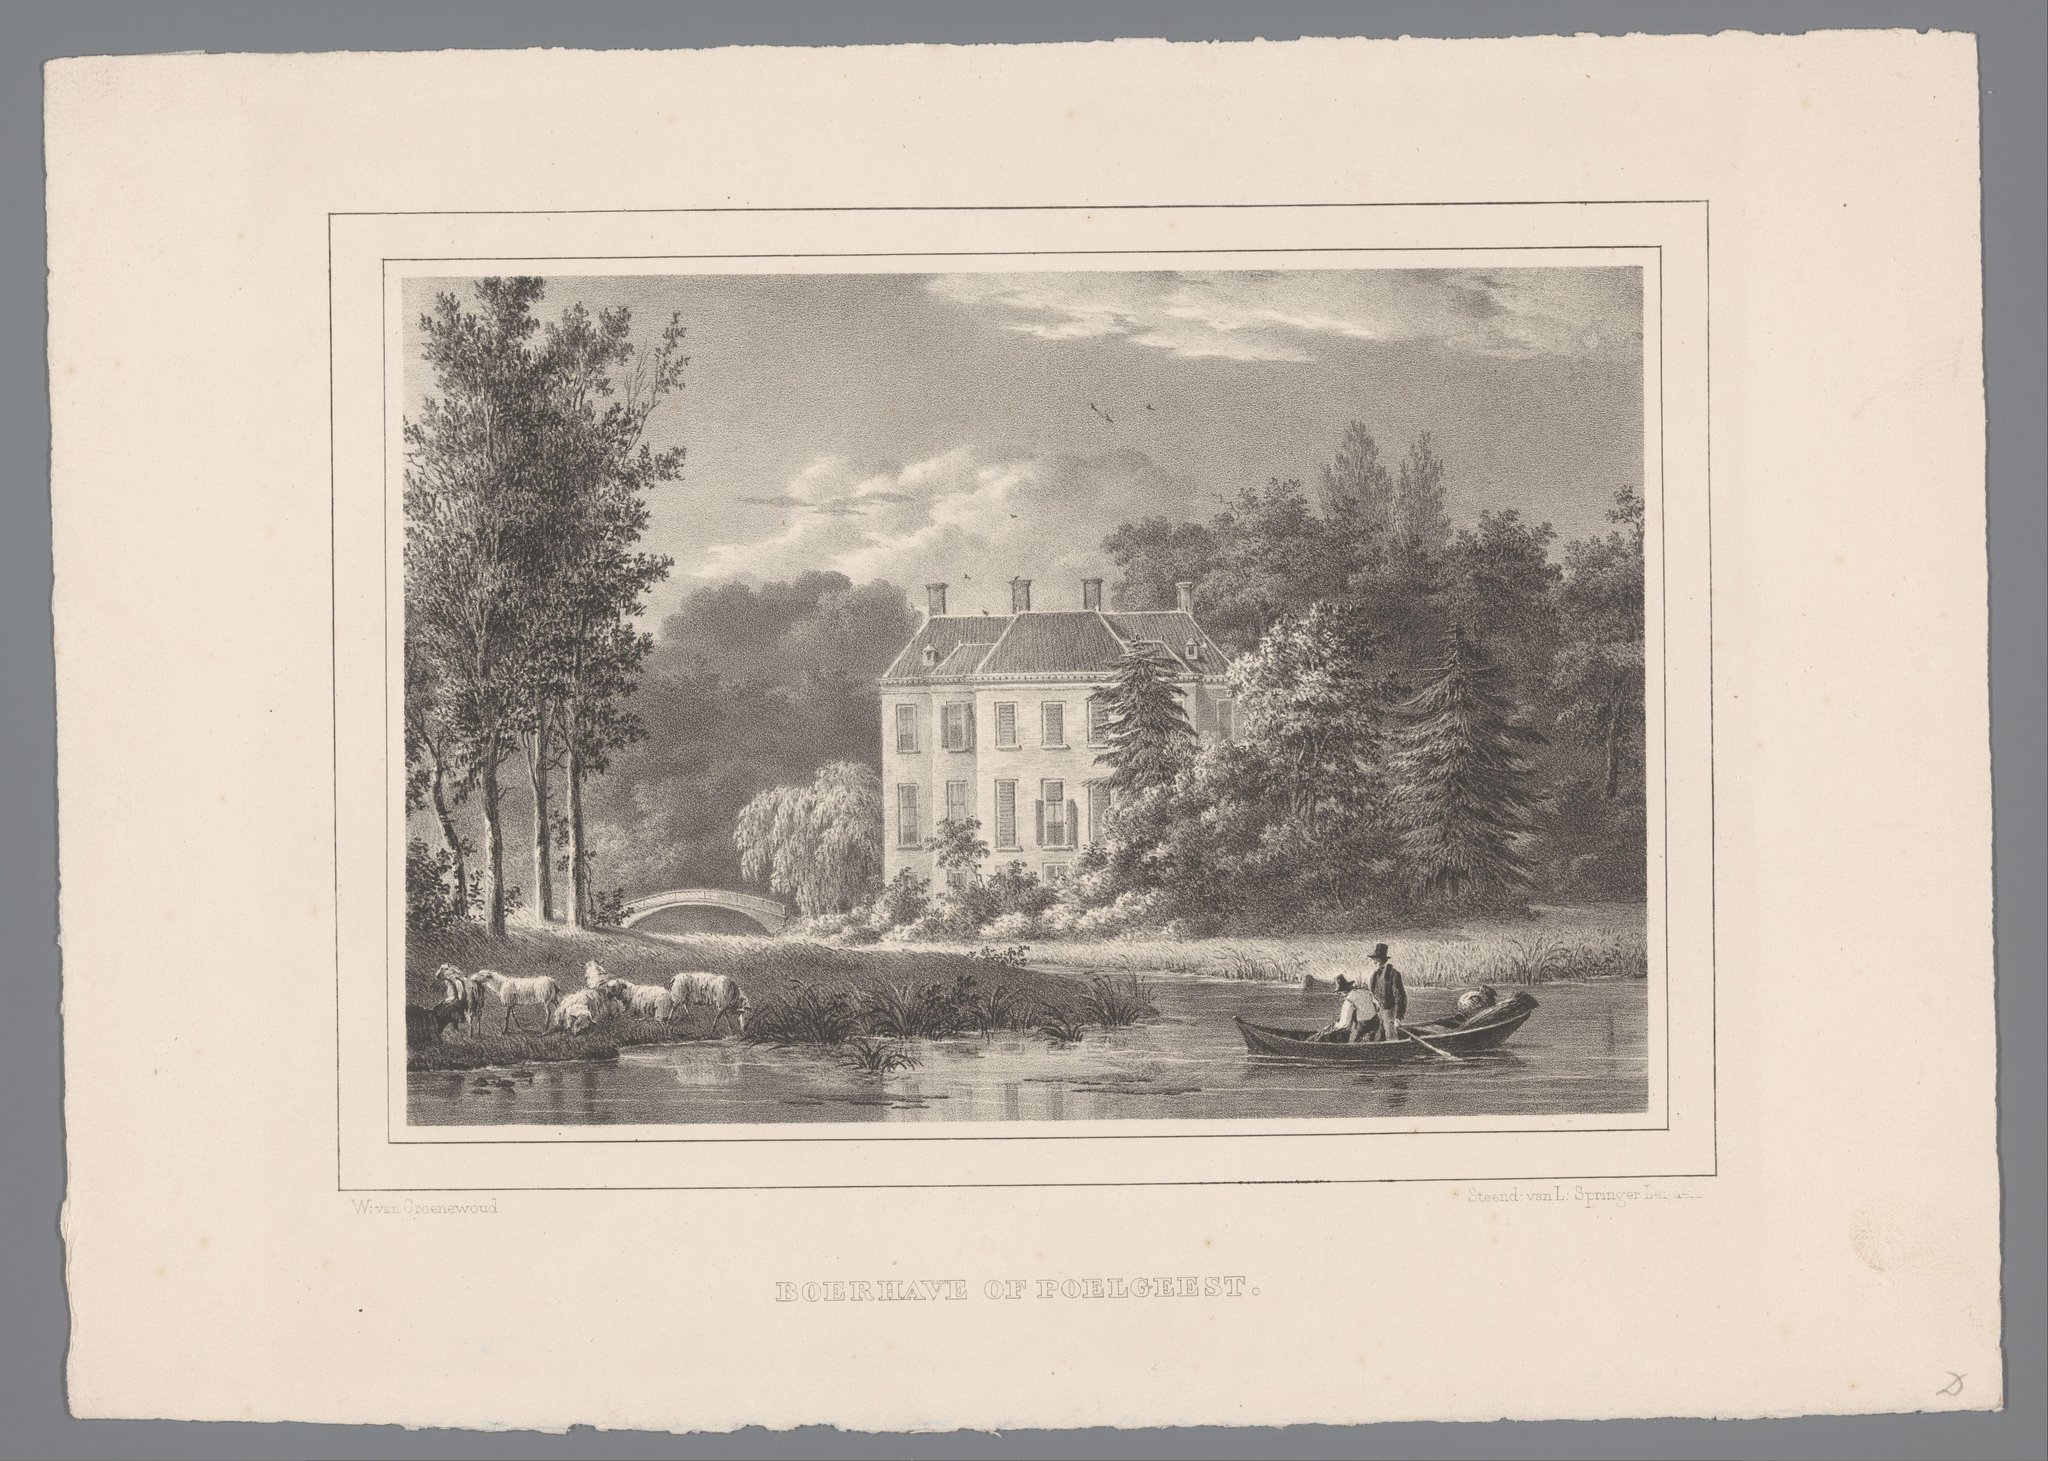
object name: print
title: Boerhave of Poelgeest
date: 1830-1863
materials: paper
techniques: lithograph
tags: castle